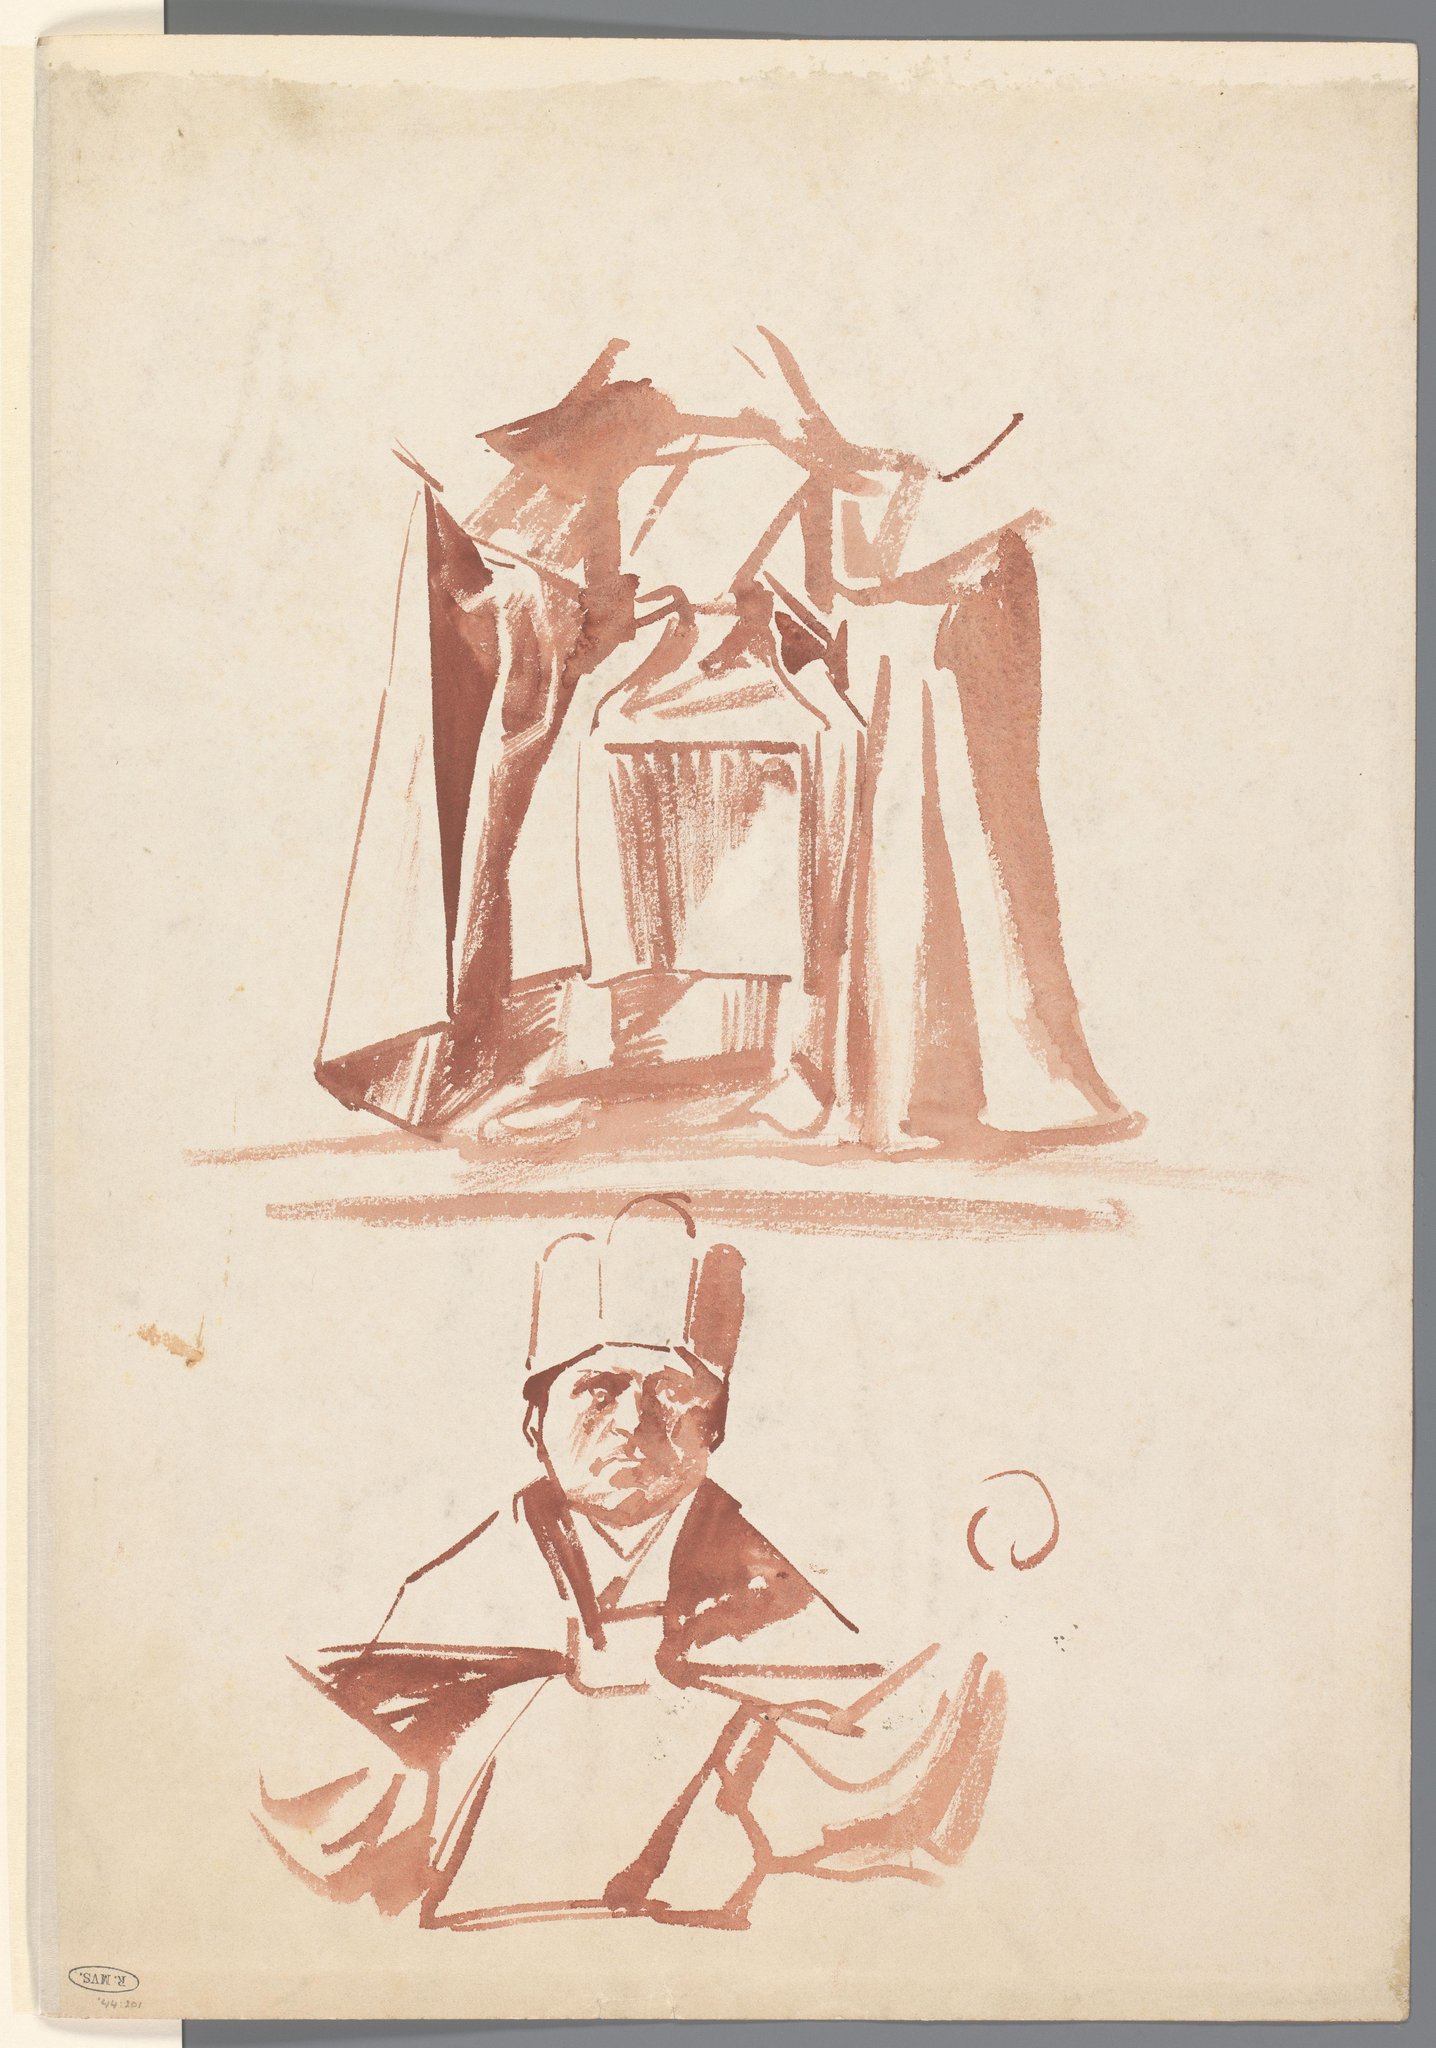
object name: drawing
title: Voorstudie voor de Eerste Bossche Wand: Keizer Frederik Barbarossa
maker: antoon derkinderen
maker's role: draughtsman, painter, print maker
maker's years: 1859-1925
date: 1869-1925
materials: paper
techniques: brush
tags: historical persons